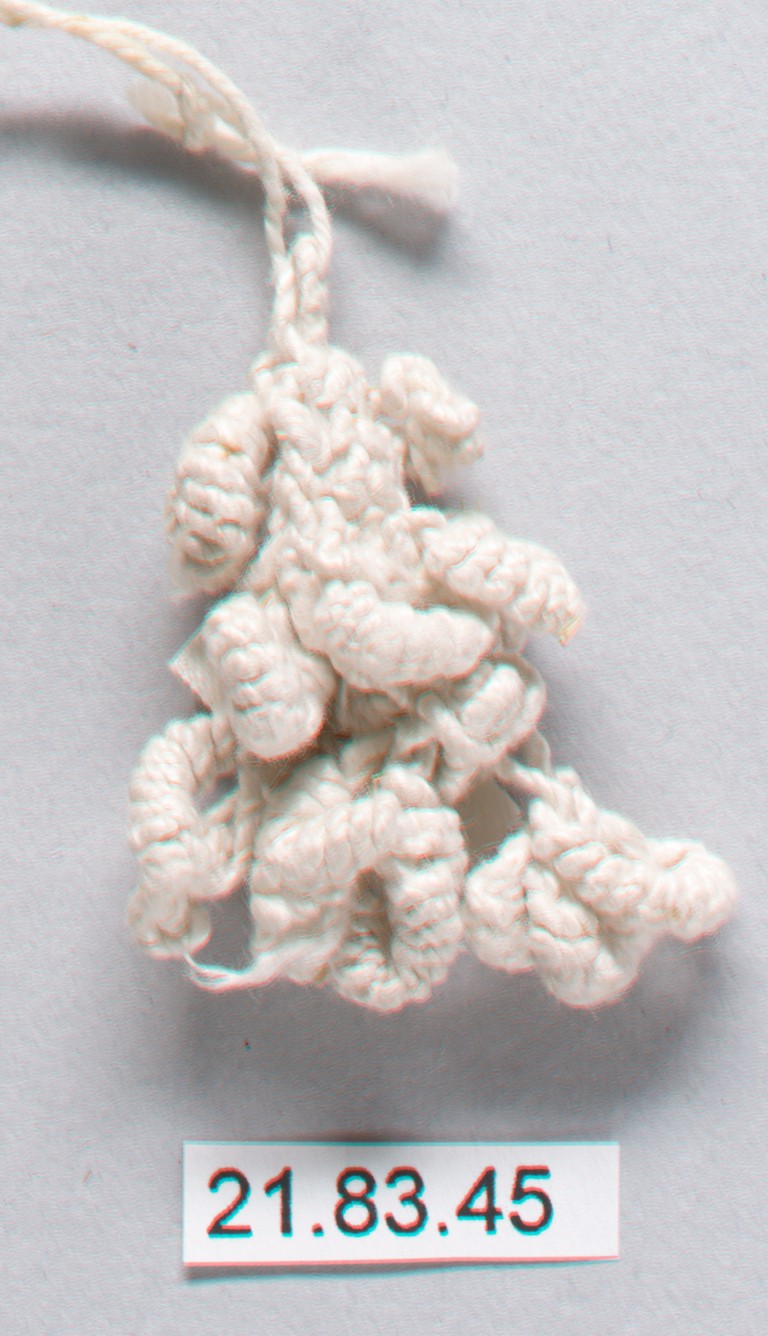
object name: tassel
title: Pair of tassels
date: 1601-1700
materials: linen